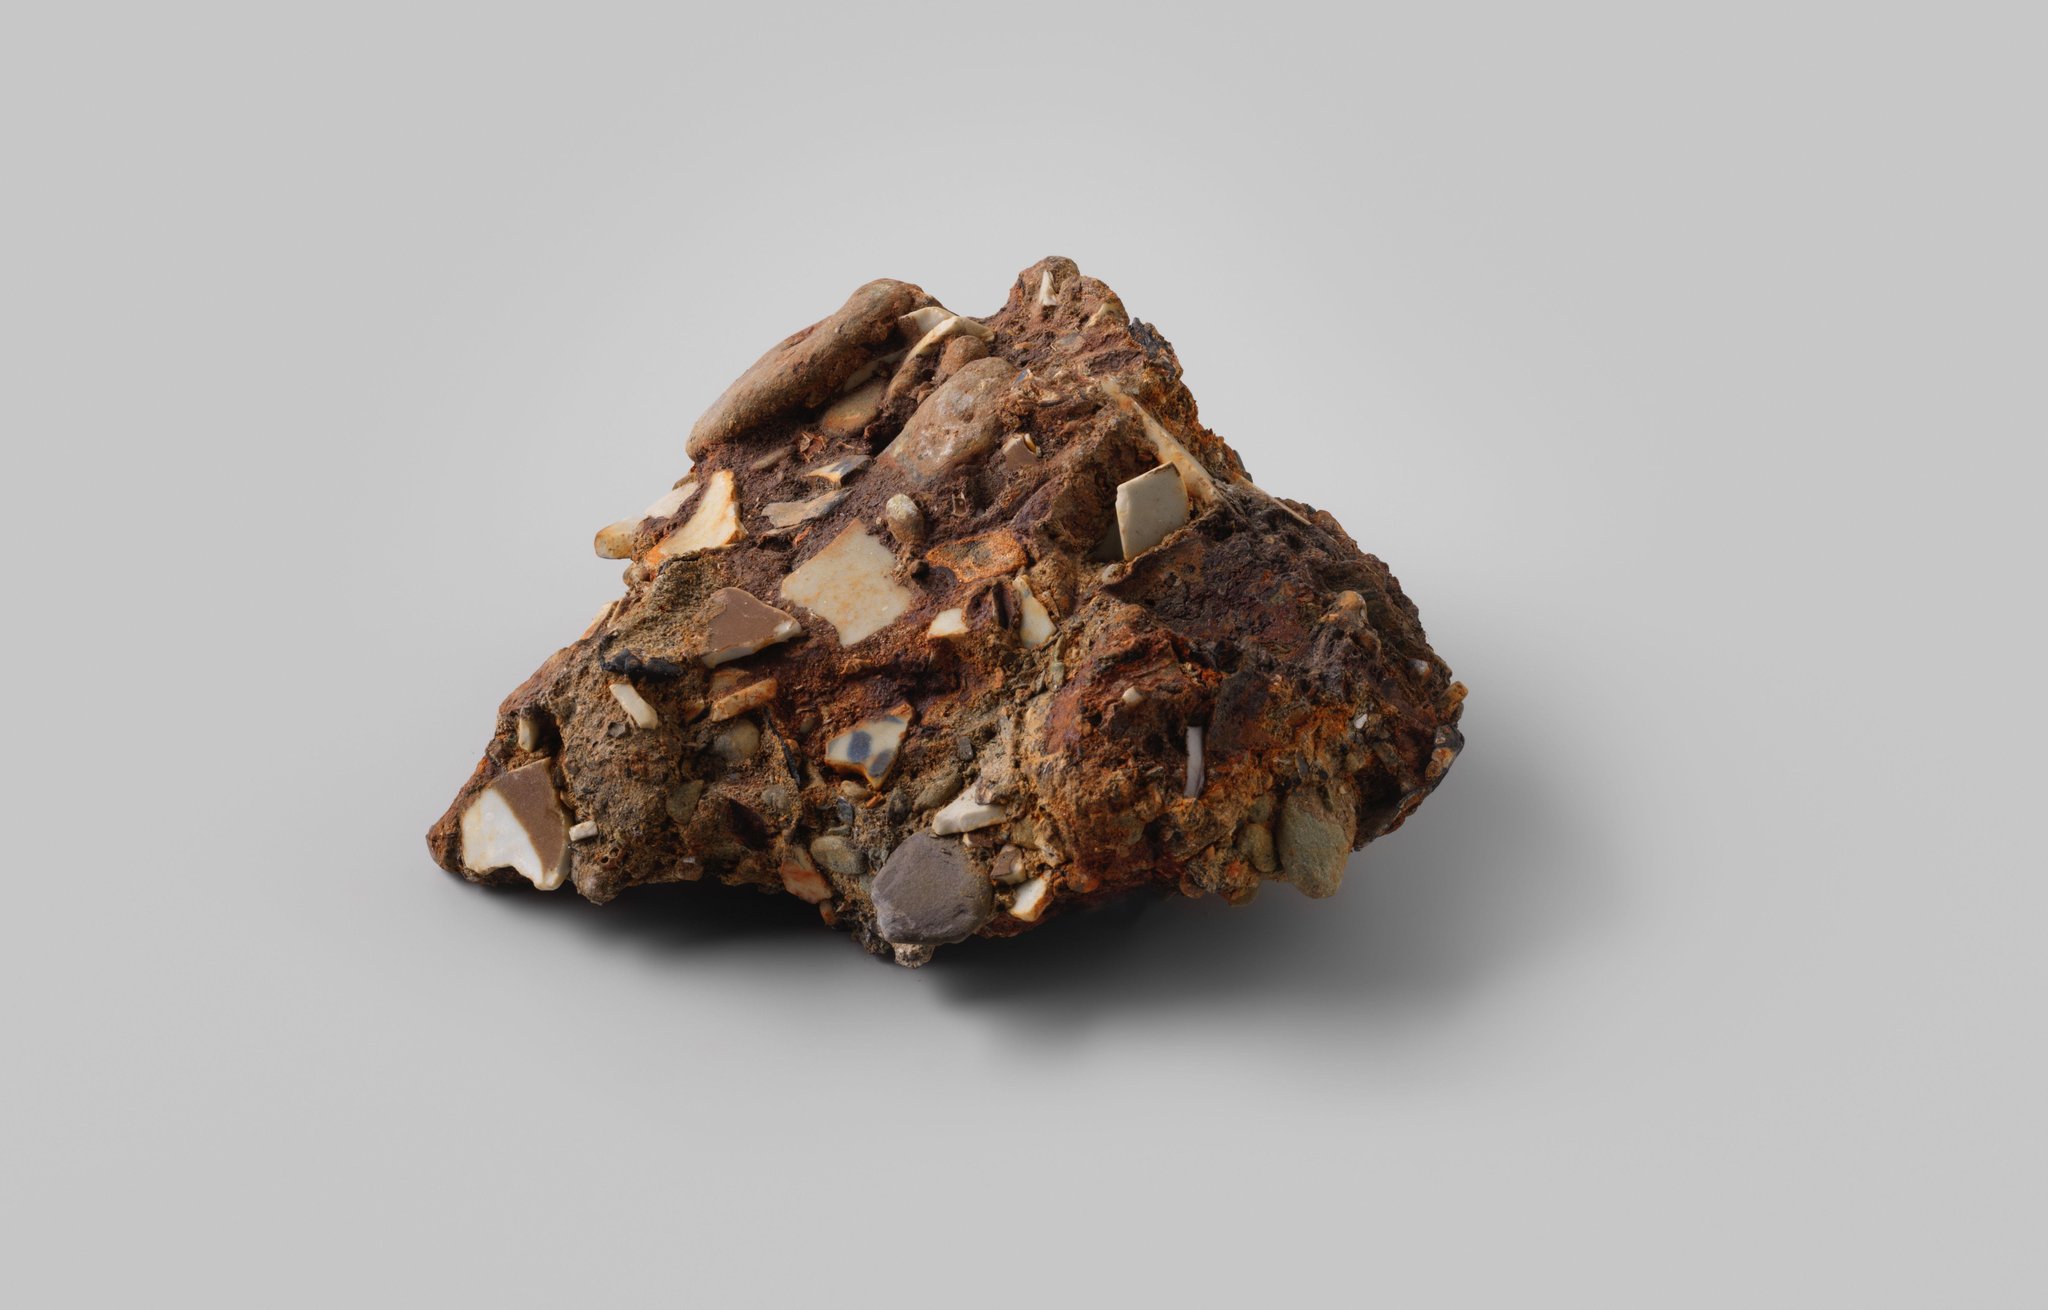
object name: concretionary stone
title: Brok concretie met insluitsels van natuursteen en porselein uit het wrak van de Oostindiëvaarder Hollandia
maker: Anonymous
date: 1700-1743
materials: stone, porcelain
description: Brok concretie met insluitsels van natuursteen en porselein.